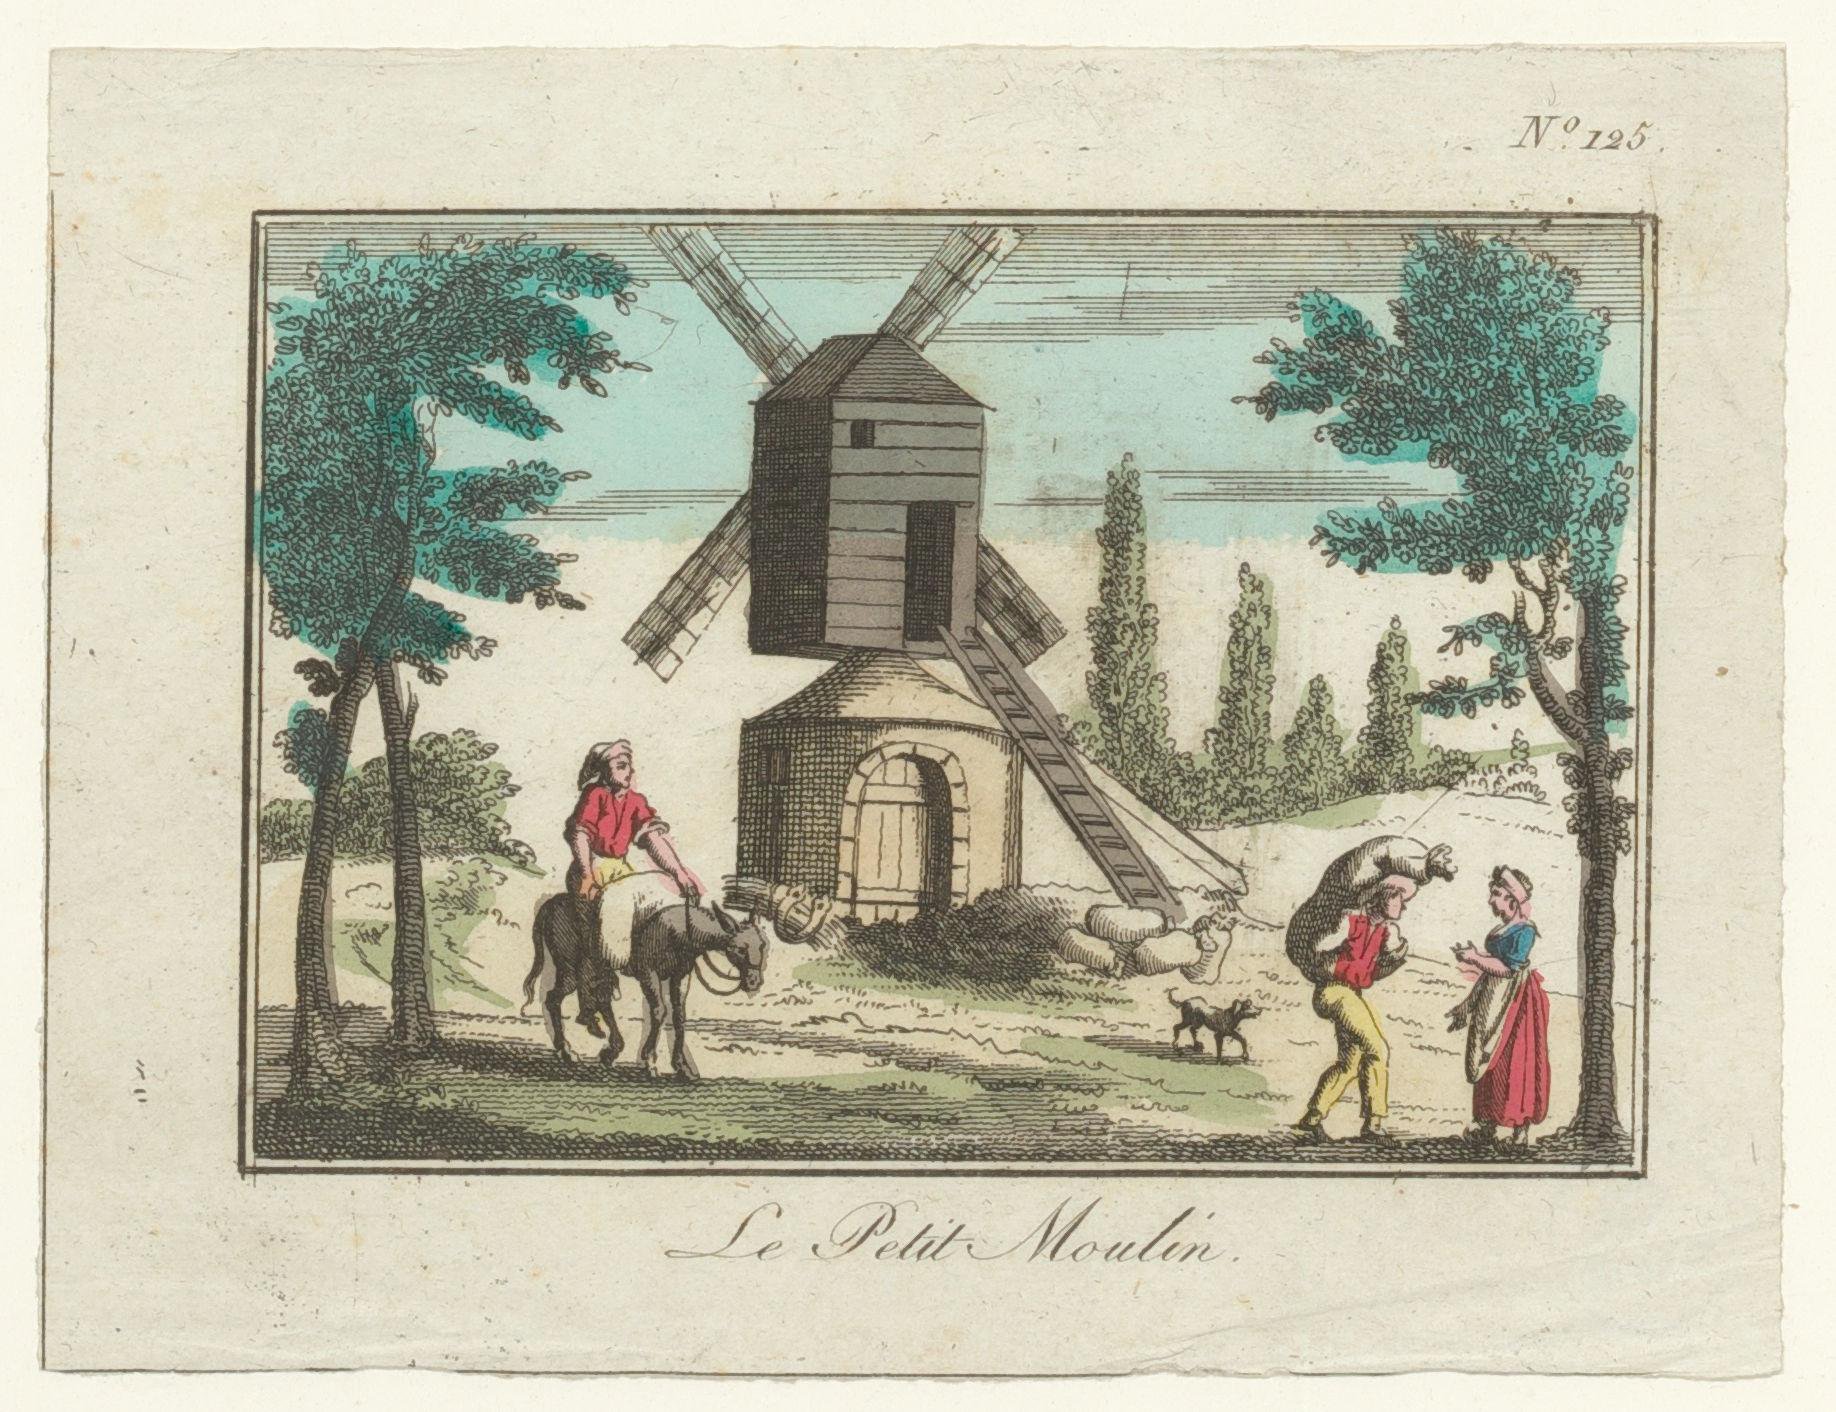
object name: print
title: Le Petit Moulin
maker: Anonymous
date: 1700-1799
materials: paper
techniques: etching, hand coloring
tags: windmill in landscape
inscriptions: stamp: Lugt 1641a, collector's mark: Lugt 1641, stamp:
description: Rechtsboven genummerd: No. 125. Onderwerpsrubrieken binnen de Atlas Zeden en Gewoonten: Handel, Nijverheid en Verkeer, Beroep en bedrijf, Complete suites.